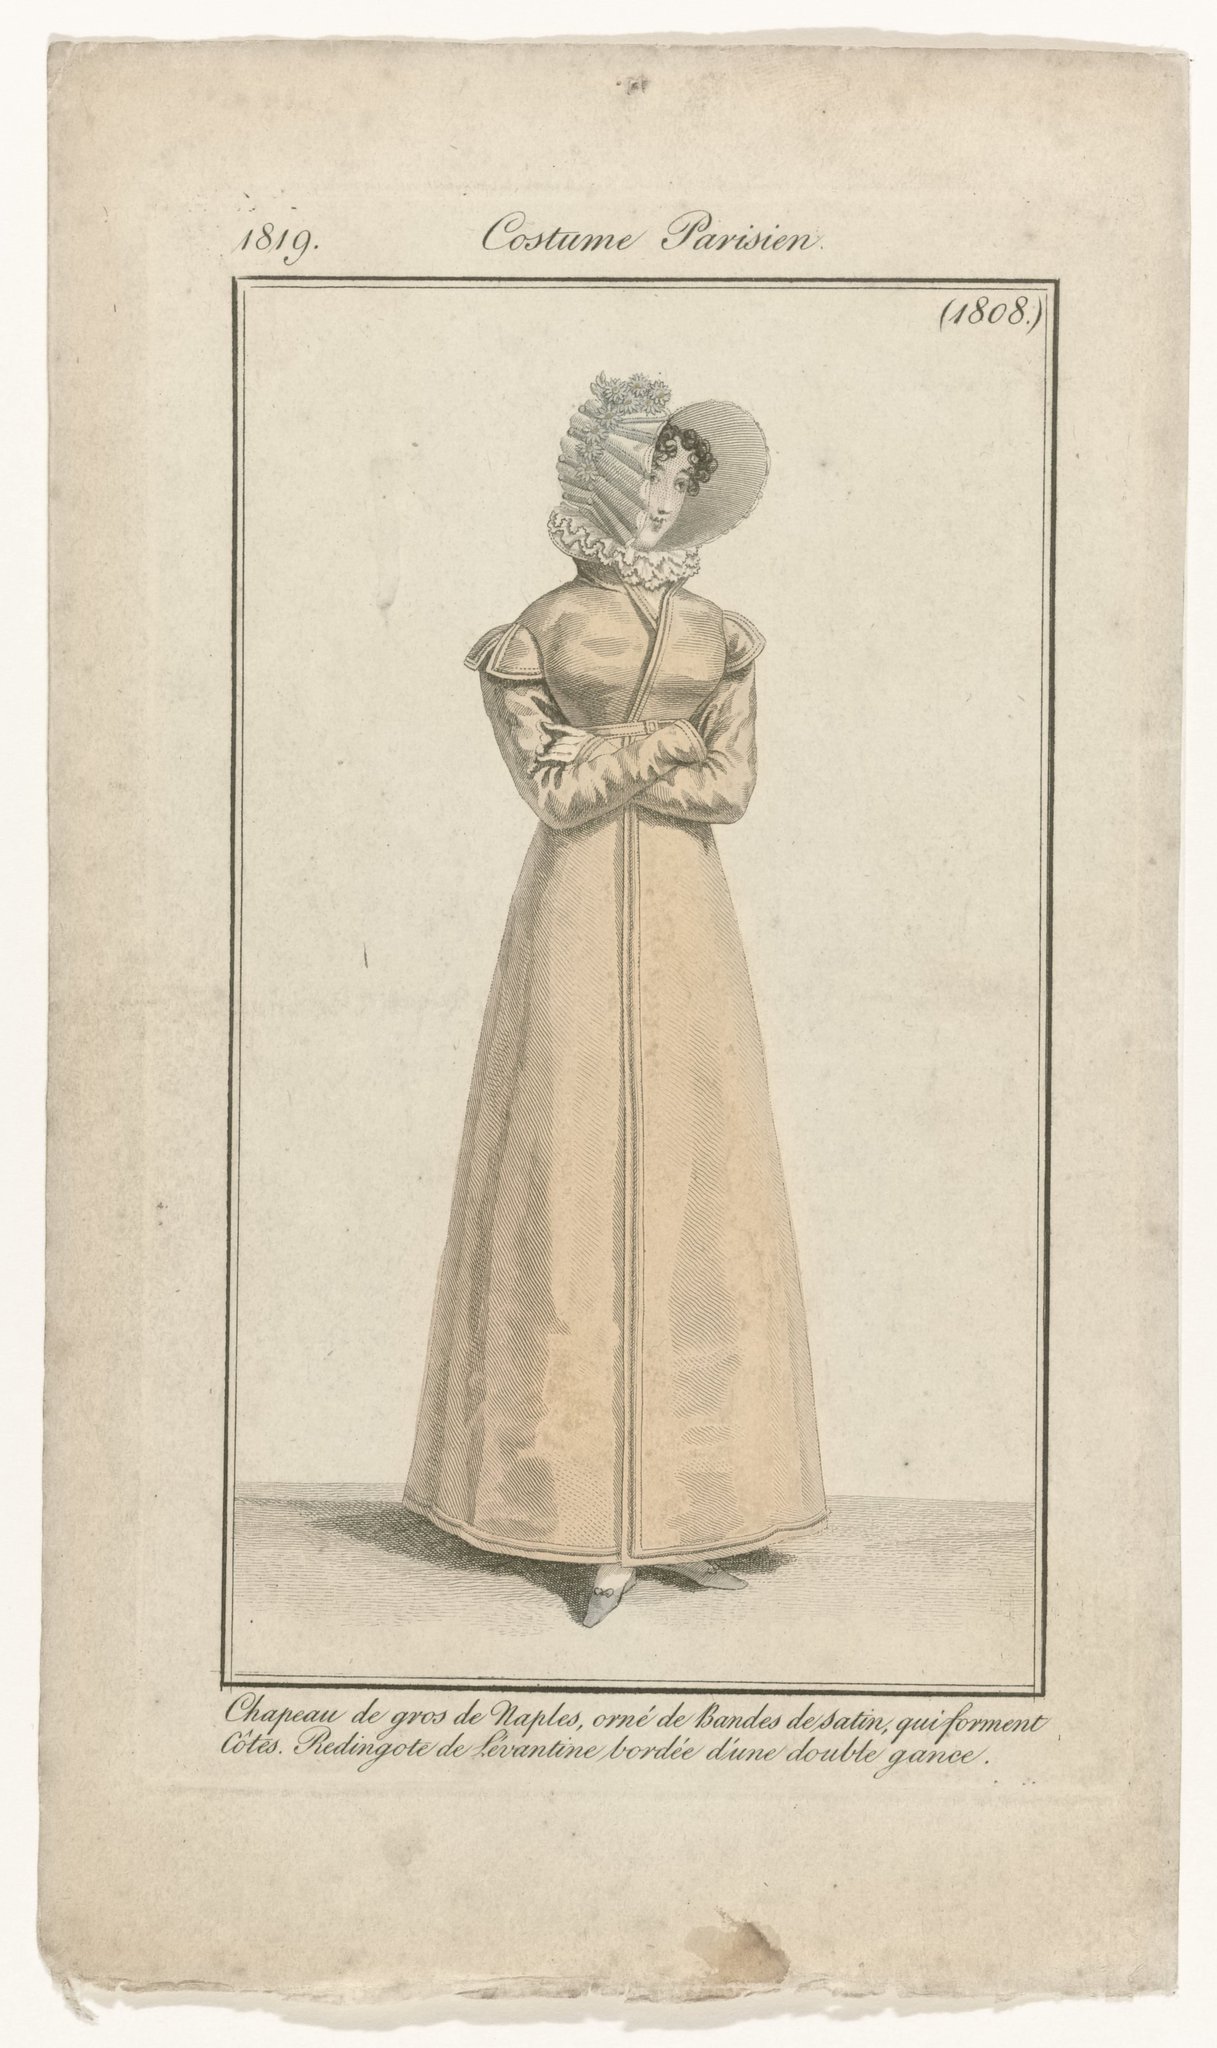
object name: fashion print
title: Journal des Dames et des Modes, Costume Parisien, 1819, (1808): Chapeau de gros de Naples (...)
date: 1819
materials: paper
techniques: engraving, hand coloring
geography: paris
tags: border, ribbon, braid (+ women's clothes), dress, gown: redingote (+ women's clothes), fashion plates, head-gear: hat (+ women's clothes), shoes, sandals (+ women's clothes)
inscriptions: caption: ‘Chapeau de gros de Naples, orné de Bandes de satin, qui forment Côtes. Redingote de Lévantine bordée d'une double gance.’, title: ‘Costume Parisien.’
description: Vrouw, staande met de armen over elkaar, gekleed in een 'redingote de Lévantine' afgezet met een dubbele 'gance'(bies). Op het hoofd een luifelhoed van 'gros de Naples' versierd met satijnen banden. De prent maakt deel uit van het modetijdschrift Journal des Dames et des Modes, uitgegeven door Pierre de la Mésangère, Parijs, 1797-1839.